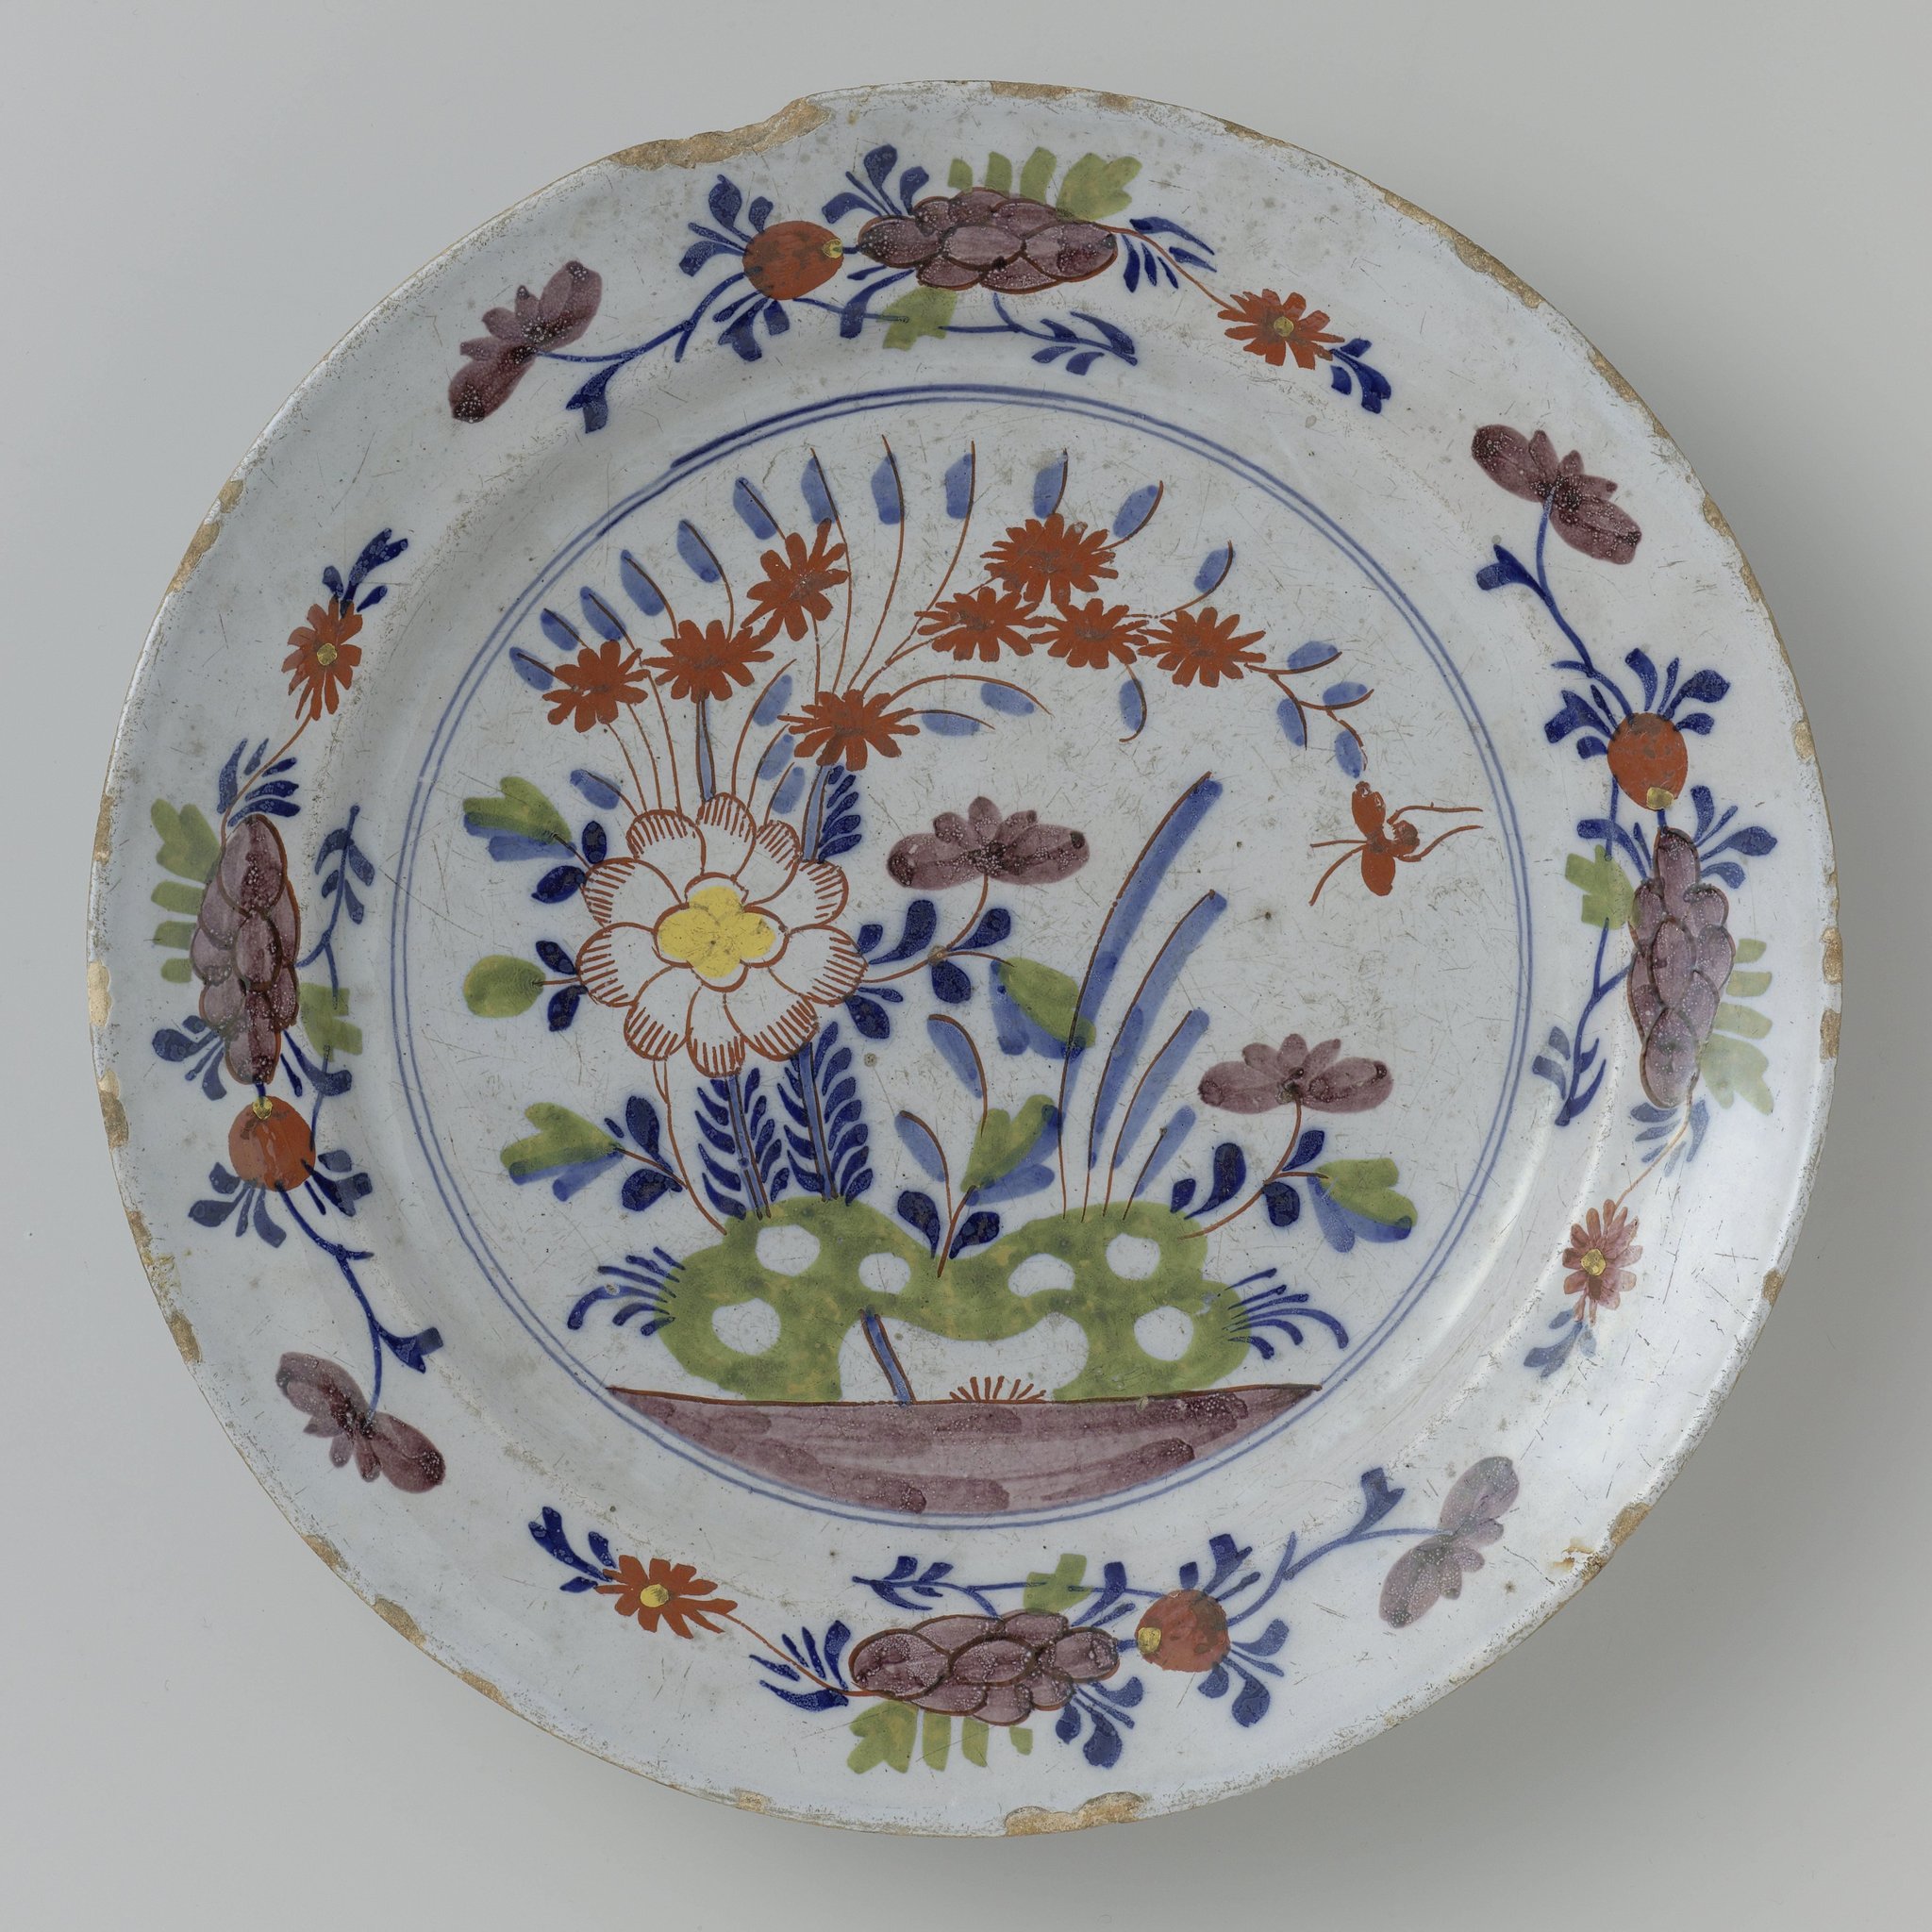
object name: platter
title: Schotel van faience met bloemen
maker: Anonymous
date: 1750-1780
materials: earthenware, glaze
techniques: painted, polychromy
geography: delft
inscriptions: mark: ‘1’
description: Ronde schotel van veelkleurige faience, met op het plat bloemen en planten op een grond. Op de rand zijn bloemen geschilderd.